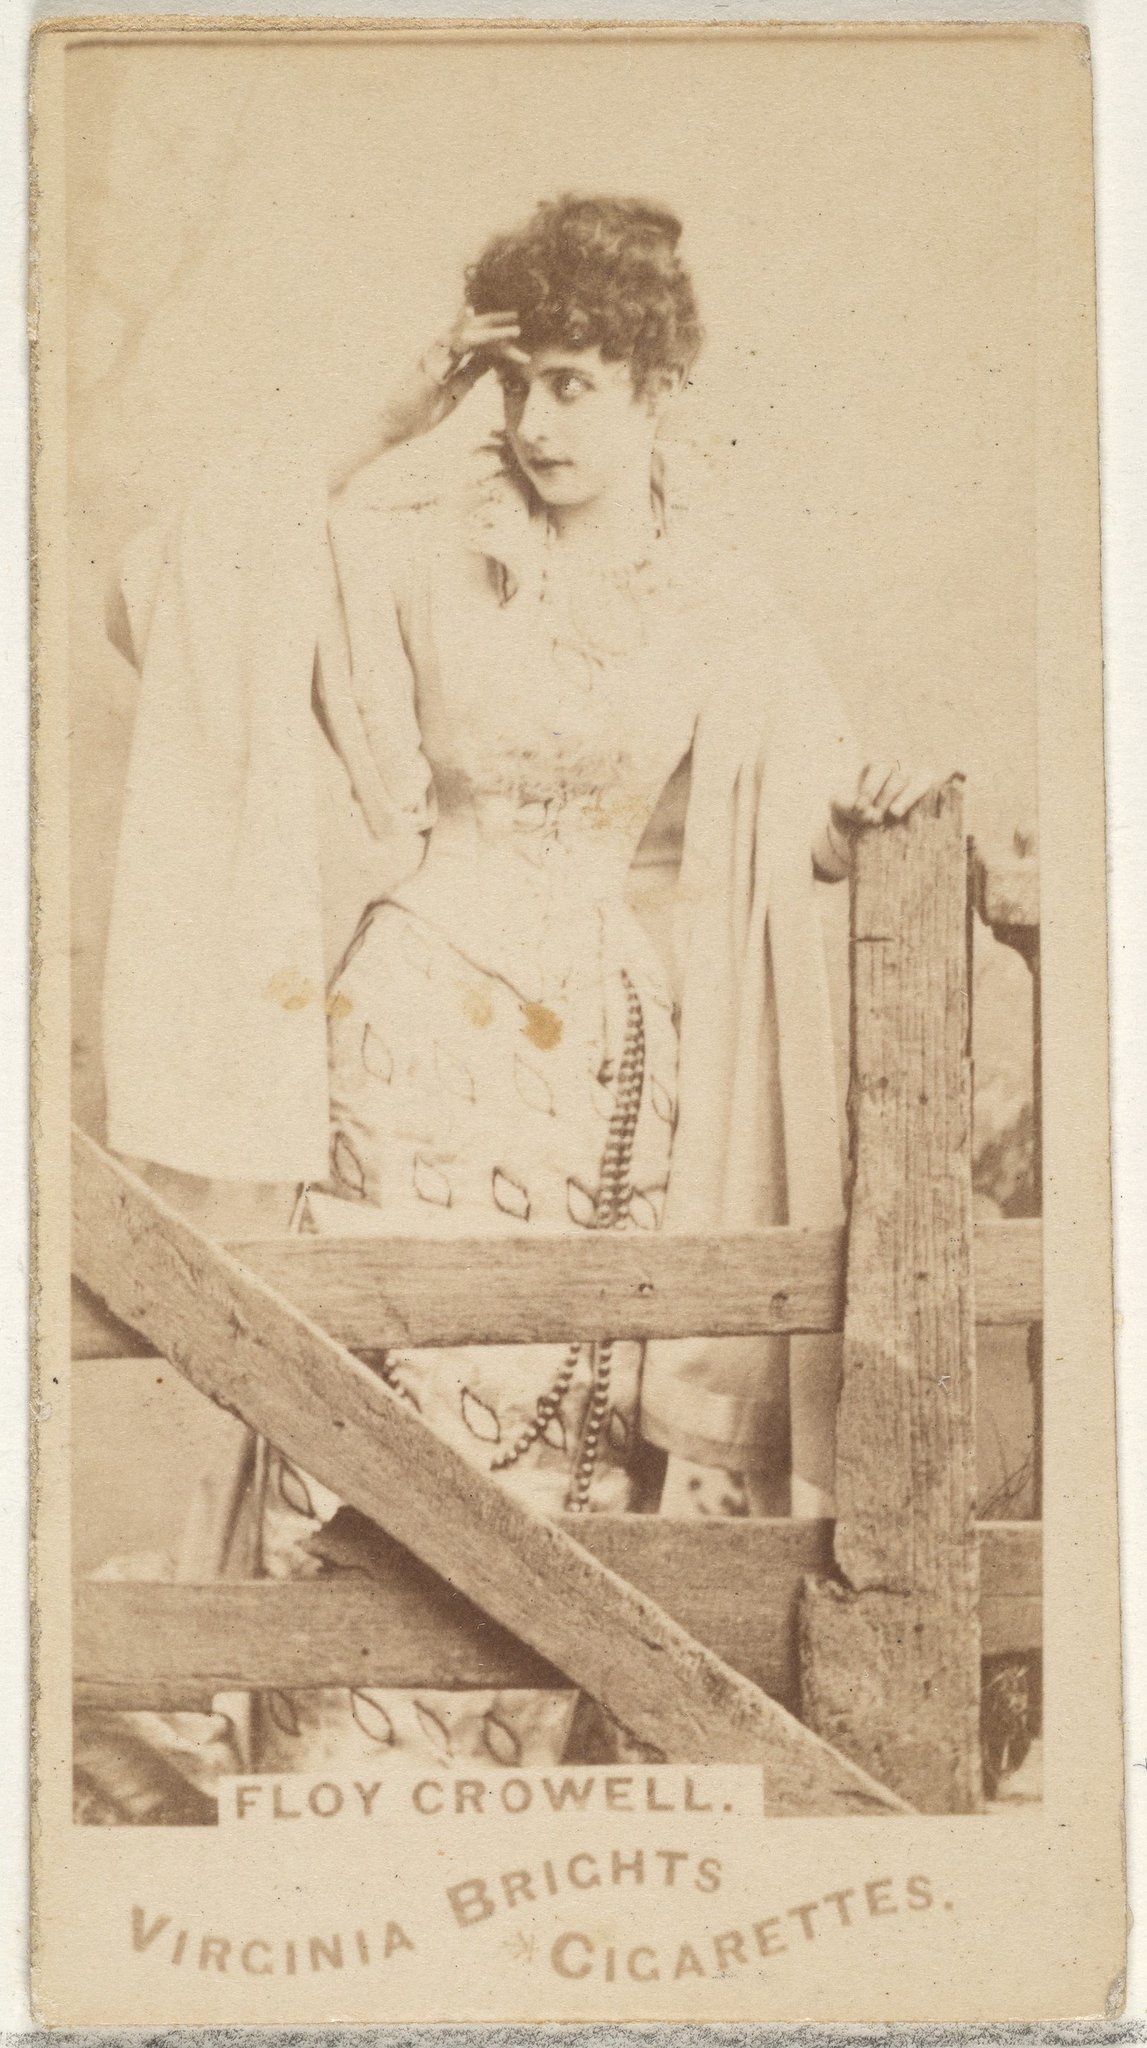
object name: photograph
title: Floy Crowell, from the Actors and Actresses series (N45, Type 1) for Virginia Brights Cigarettes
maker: allen & ginter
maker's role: publisher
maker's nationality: american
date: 1888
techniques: albumen silver print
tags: portraits,women,actresses